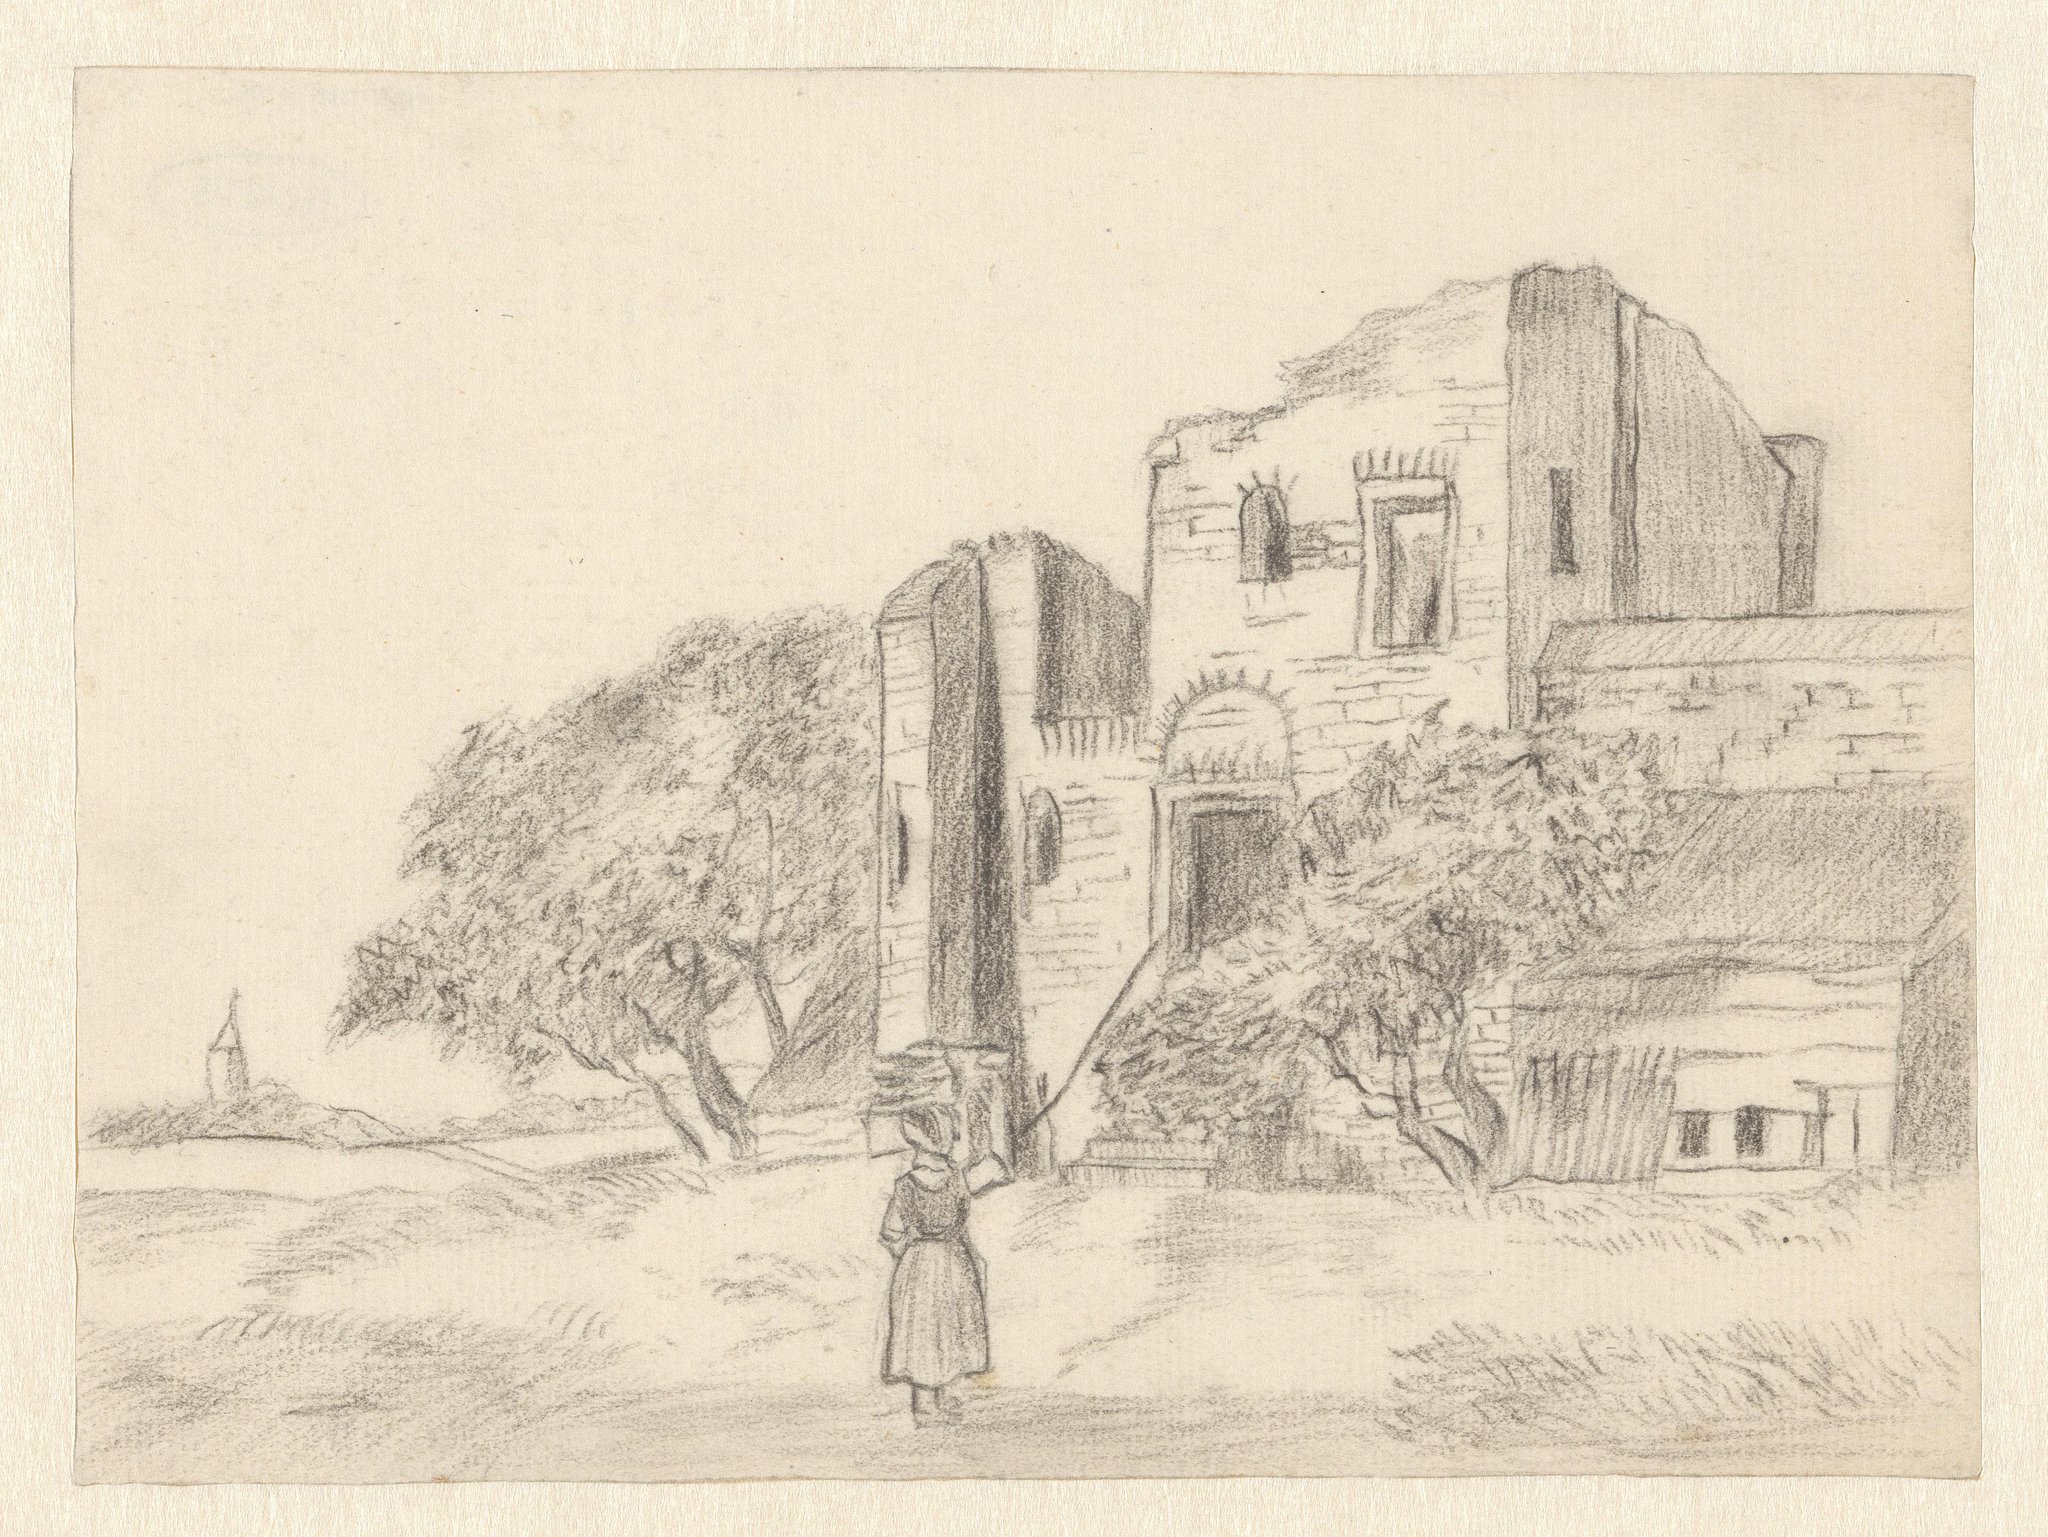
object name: drawing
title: Landschap met een ruïne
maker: joannes carolus alberdingk thijm (jan)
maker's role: pater, schrijver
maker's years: 1847-1926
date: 1850-1853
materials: chalk, paper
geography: netherlands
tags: landscape with ruins